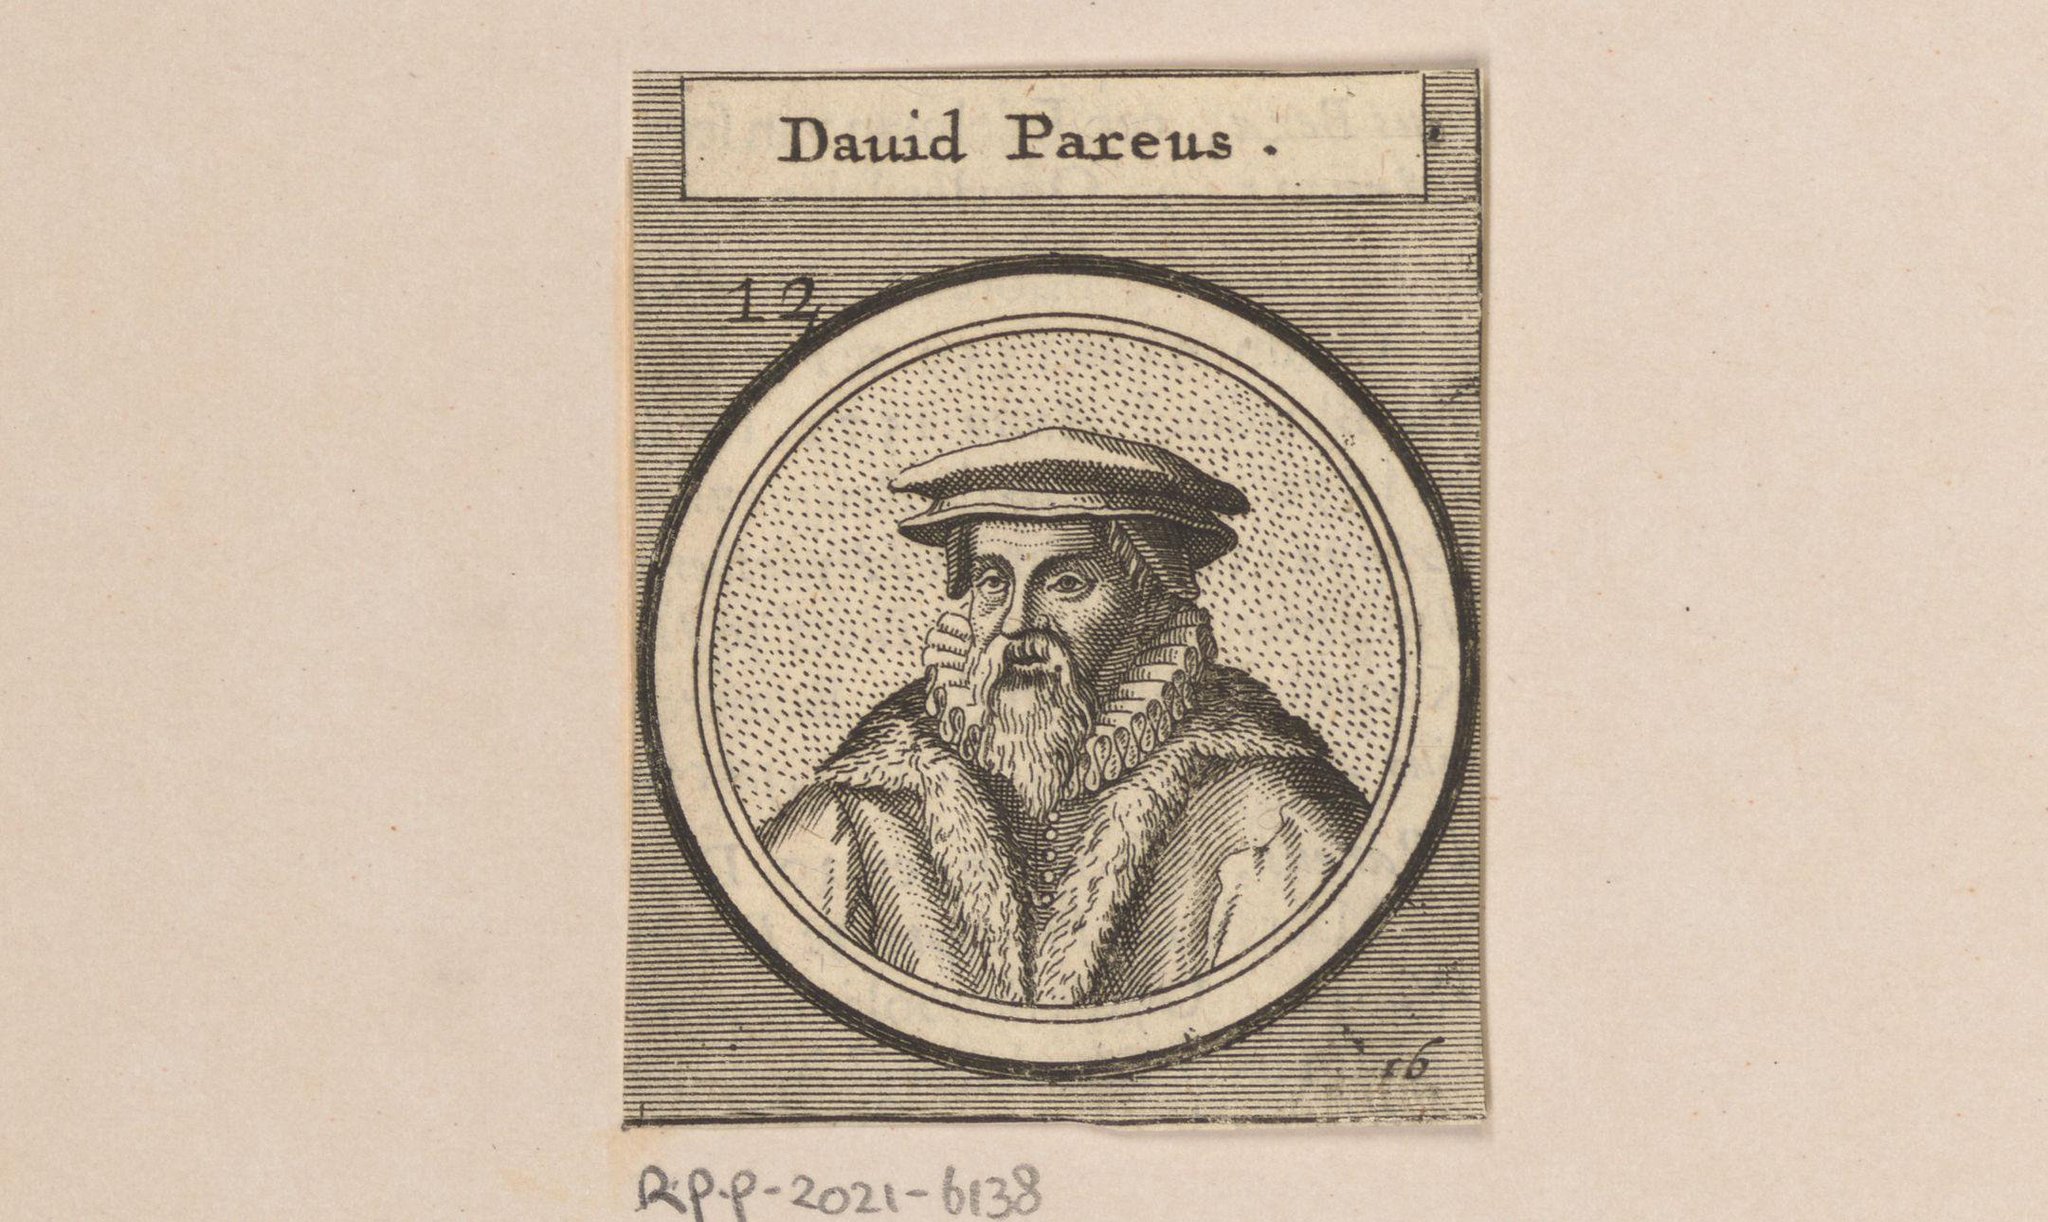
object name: book illustration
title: Portret van David Pareus II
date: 1698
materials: paper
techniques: engraving, etching, letterpress printing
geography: leiden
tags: adult man, historical persons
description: Prent uit: Gottfried, Johann Ludwig. Historische kronyck (...). Leiden: Pieter van der Aa, 1698. De prent maakt onderdeel uit van een grotere plaat met twaalf portretten.